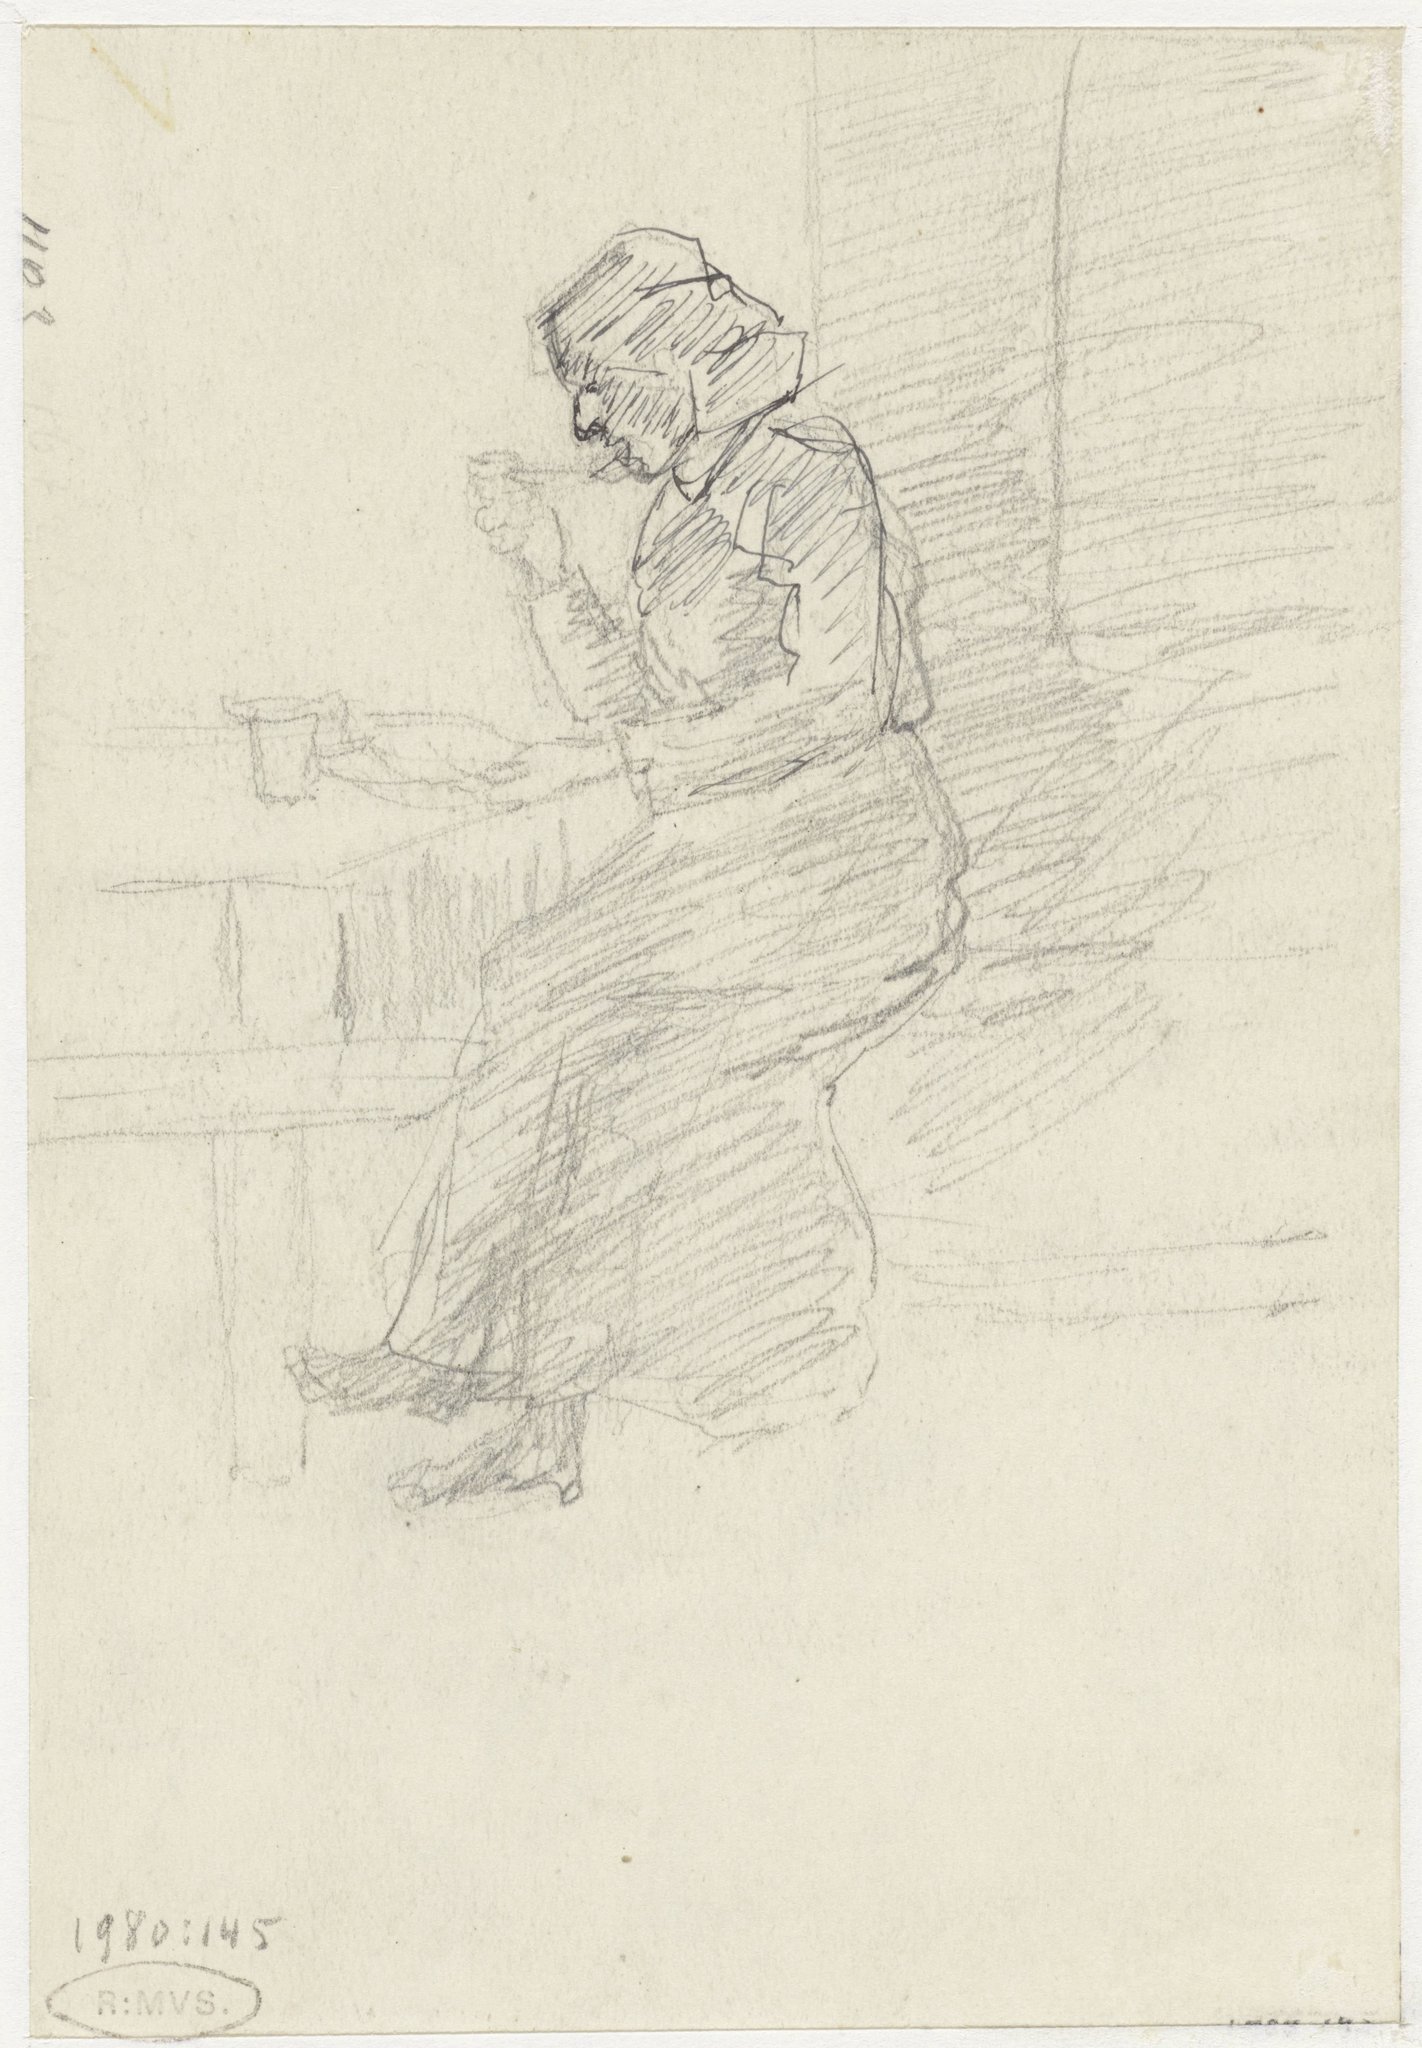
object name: drawing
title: Etende vrouw, aan tafel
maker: jozef israëls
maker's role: draughtsman, painter, print maker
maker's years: 1824-1911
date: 1834-1911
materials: ink, paper, pencil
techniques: pen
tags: eating